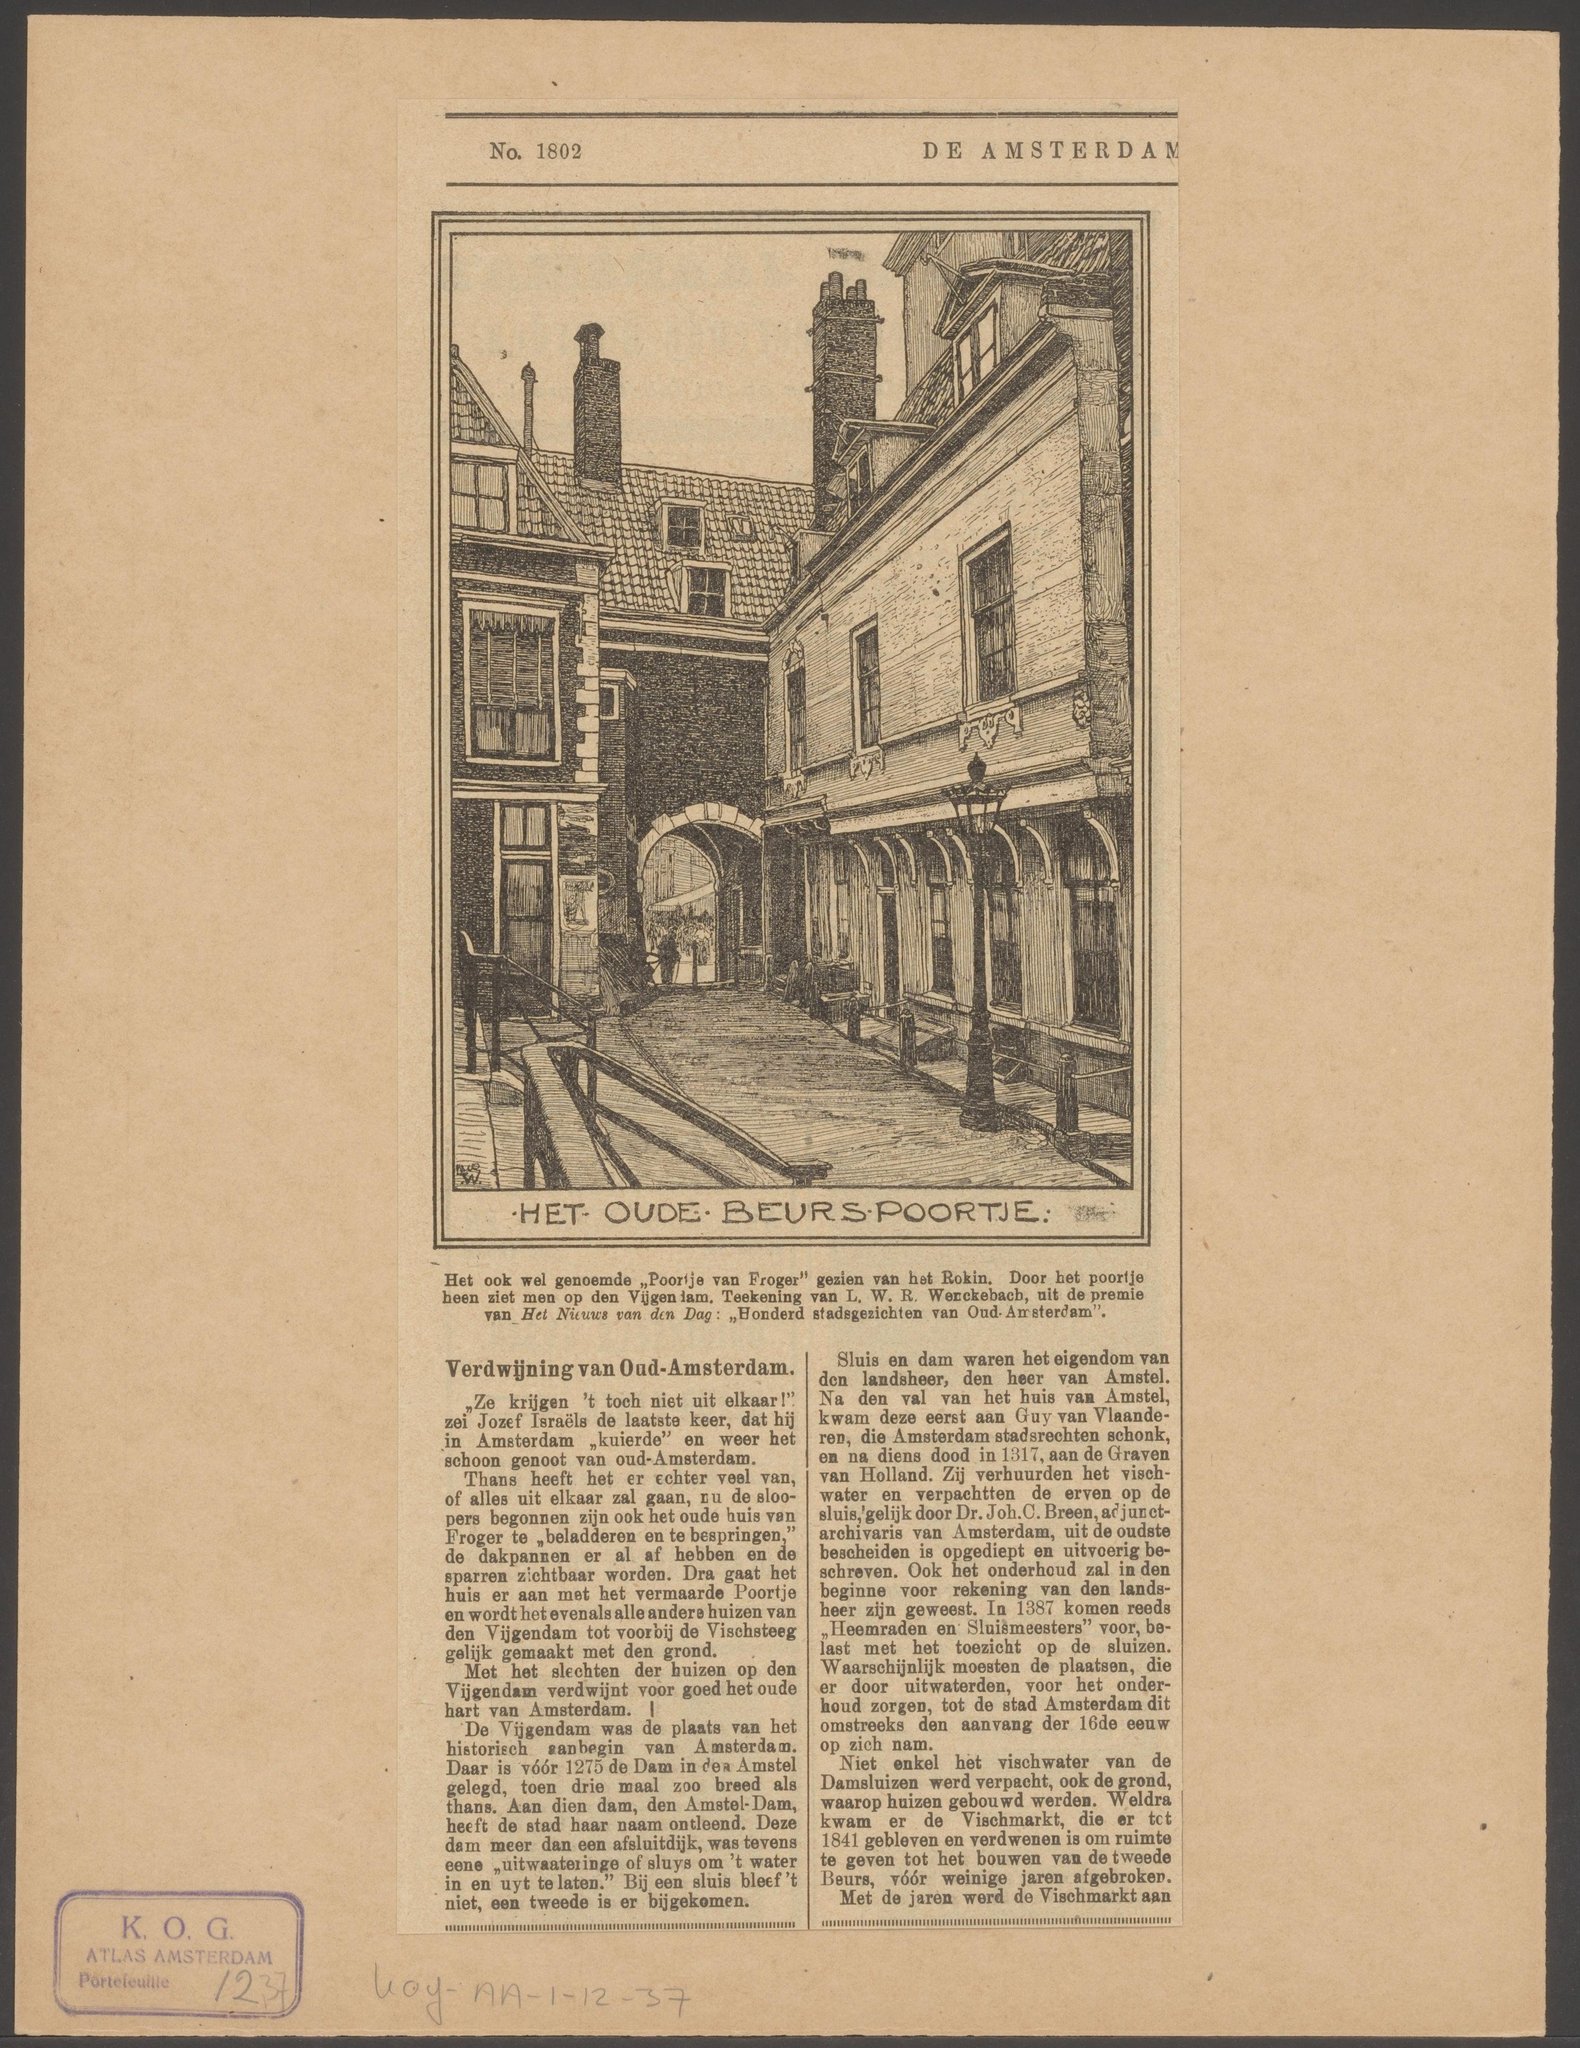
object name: page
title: Gezicht op het Beurspoortje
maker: willem wenckebach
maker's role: designer, draughtsman, painter, print maker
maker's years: 1860-1937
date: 1870-1923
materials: paper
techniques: letterpress printing, line block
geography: amsterdam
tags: city-view in general; 'veduta', gate, entrance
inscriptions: collector's mark: ‘12,37’ Lugt 1641b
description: Onderwerpsrubriek binnen de Atlas Amsterdam: Rokin, Rotterdammersloot, Rozengang, Rozengracht, Rozenstraat, Rusland, Rustenburgerstraat, Ruysdaelkade, Ruysdaelstraat, Ruyterkade (de), Ruyterweg (Admiraal de).